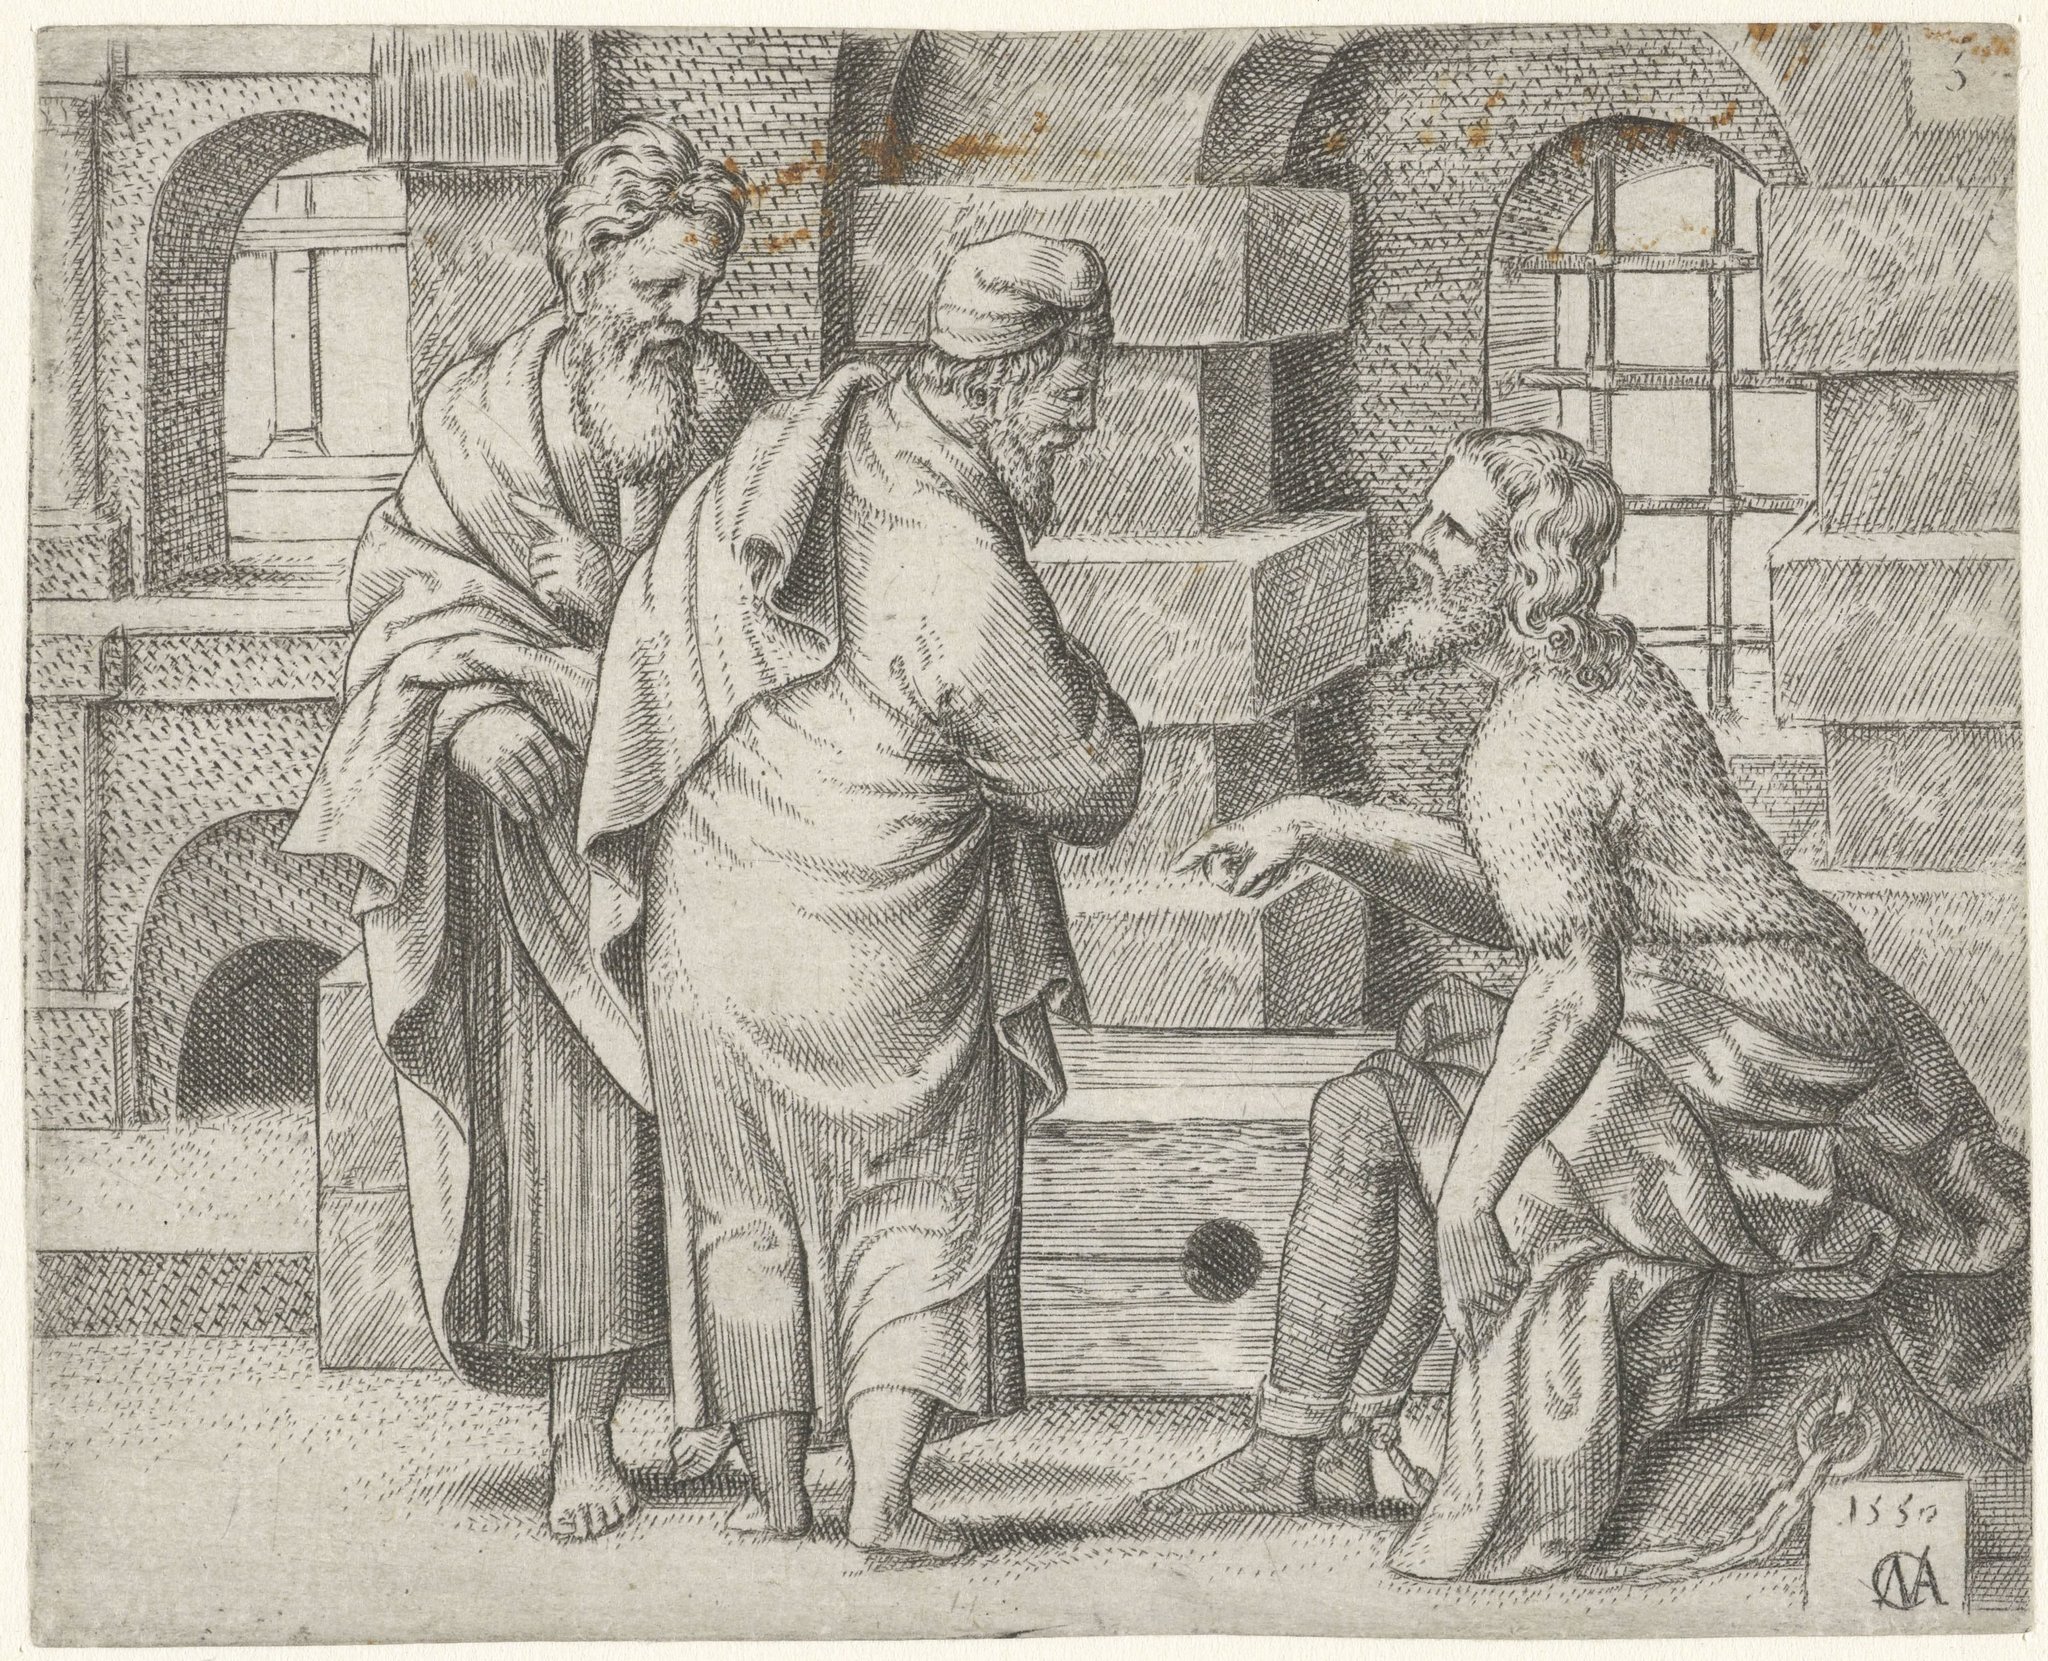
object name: print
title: Geschiedenis van Johannes de Doper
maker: cornelis massijs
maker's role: painter, print maker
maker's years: 1510-1557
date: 1550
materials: paper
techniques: engraving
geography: antwerp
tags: john the baptist in prison, two disciples of john the baptist are sent to christ (matthew 11:2-6; luke 7:18-23)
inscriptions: date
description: Johannes de Doper zit vastgeketend in de gevangenis en geeft twee van zijn discipelen de opdracht aan Christus te vragen of hij degene is die hij verwachtte.